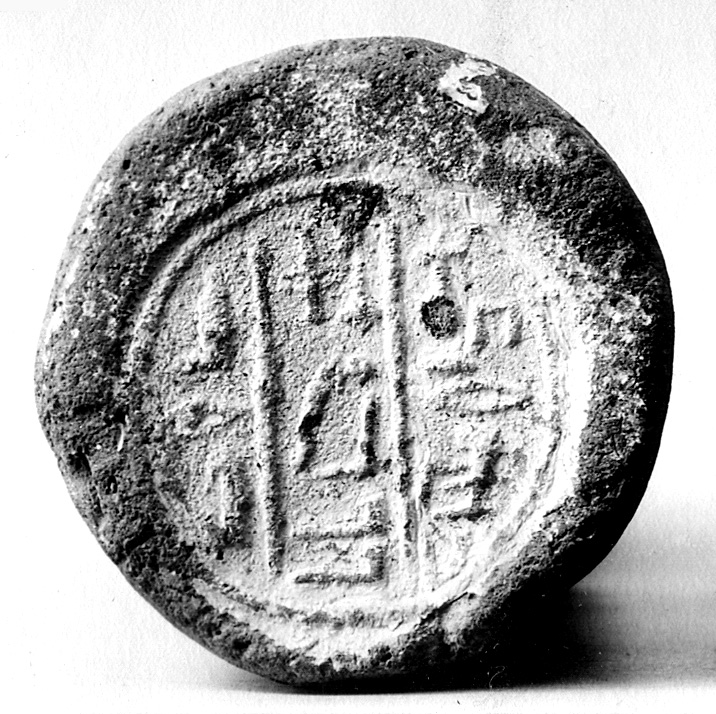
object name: cone, circular impression, nefretper, cup bearer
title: Funerary Cone of Nefretper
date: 1550-1295 BCE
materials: pottery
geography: egypt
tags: hieroglyphs